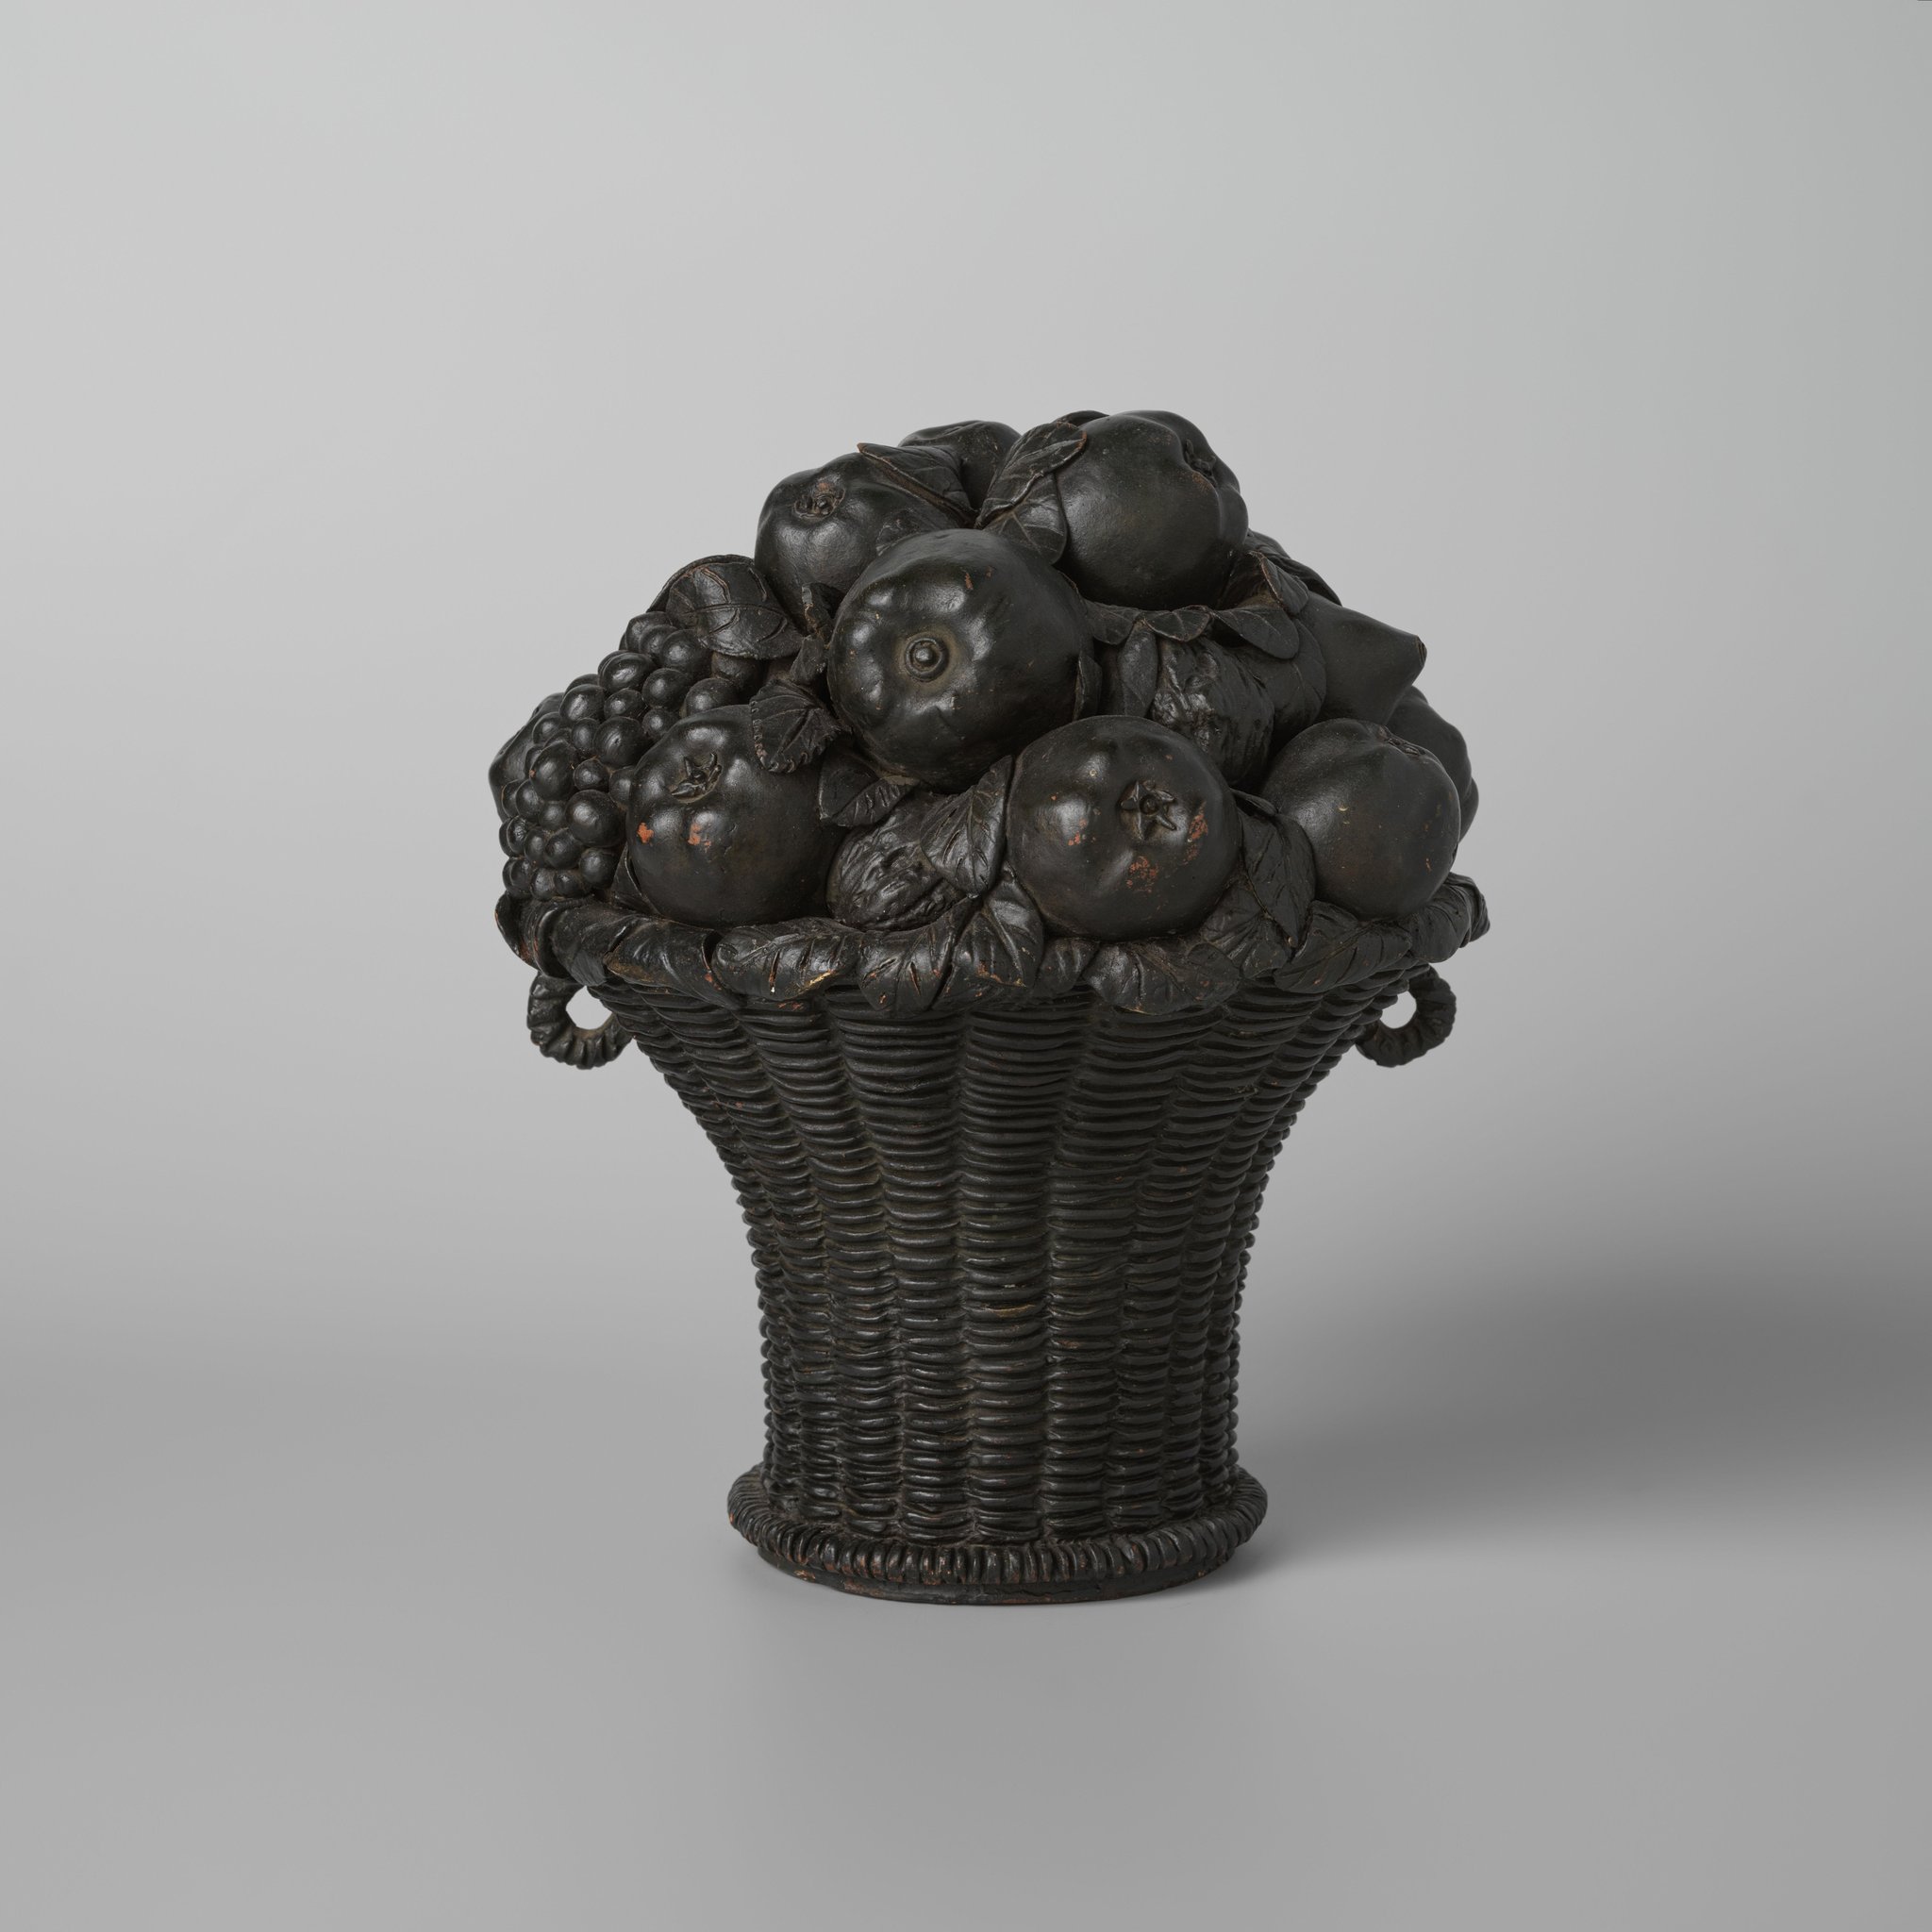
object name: decoratief object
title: Mand met vruchten van loodglazuuraardewerk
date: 1800-1825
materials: earthenware, glaze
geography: tegelen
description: Mand met vruchten van loodglazuuraardewerk. De mand met vruchten is zwart geworden en beschilderd met olieverf. Het is een kachelversiering of kachelopzet.